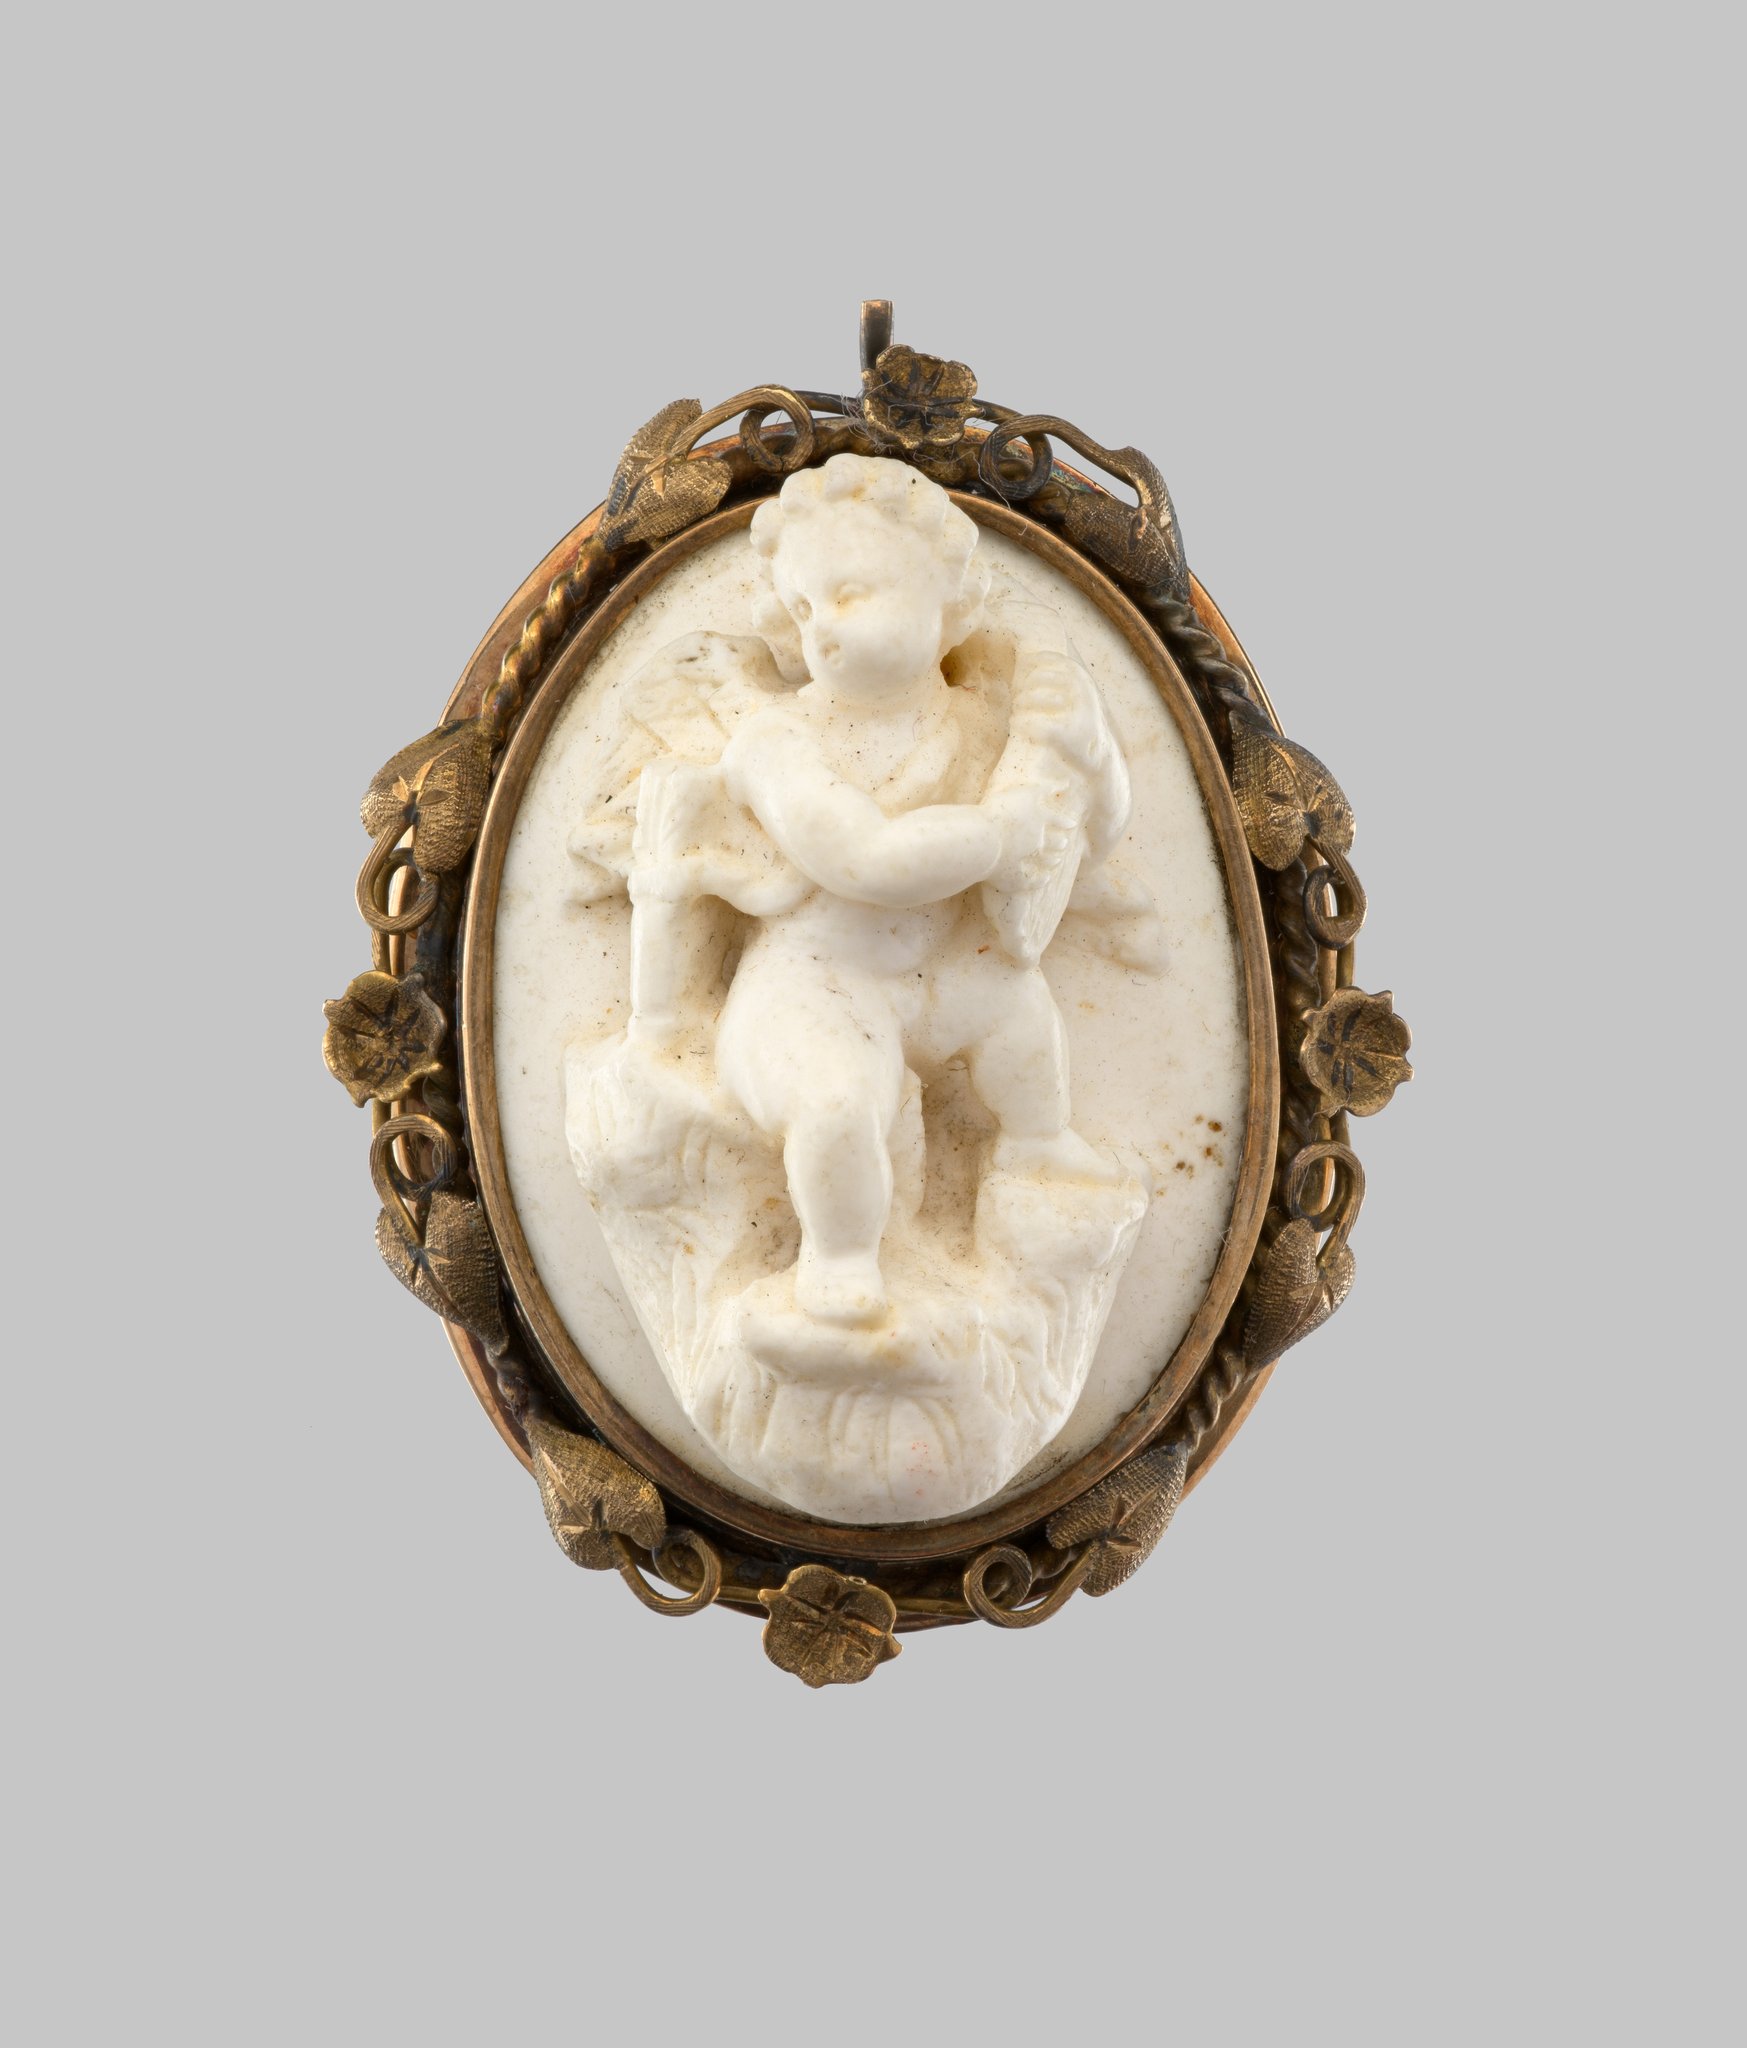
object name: earring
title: Earring (one of a pair) (part of parure)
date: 1840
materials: gold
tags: cupid